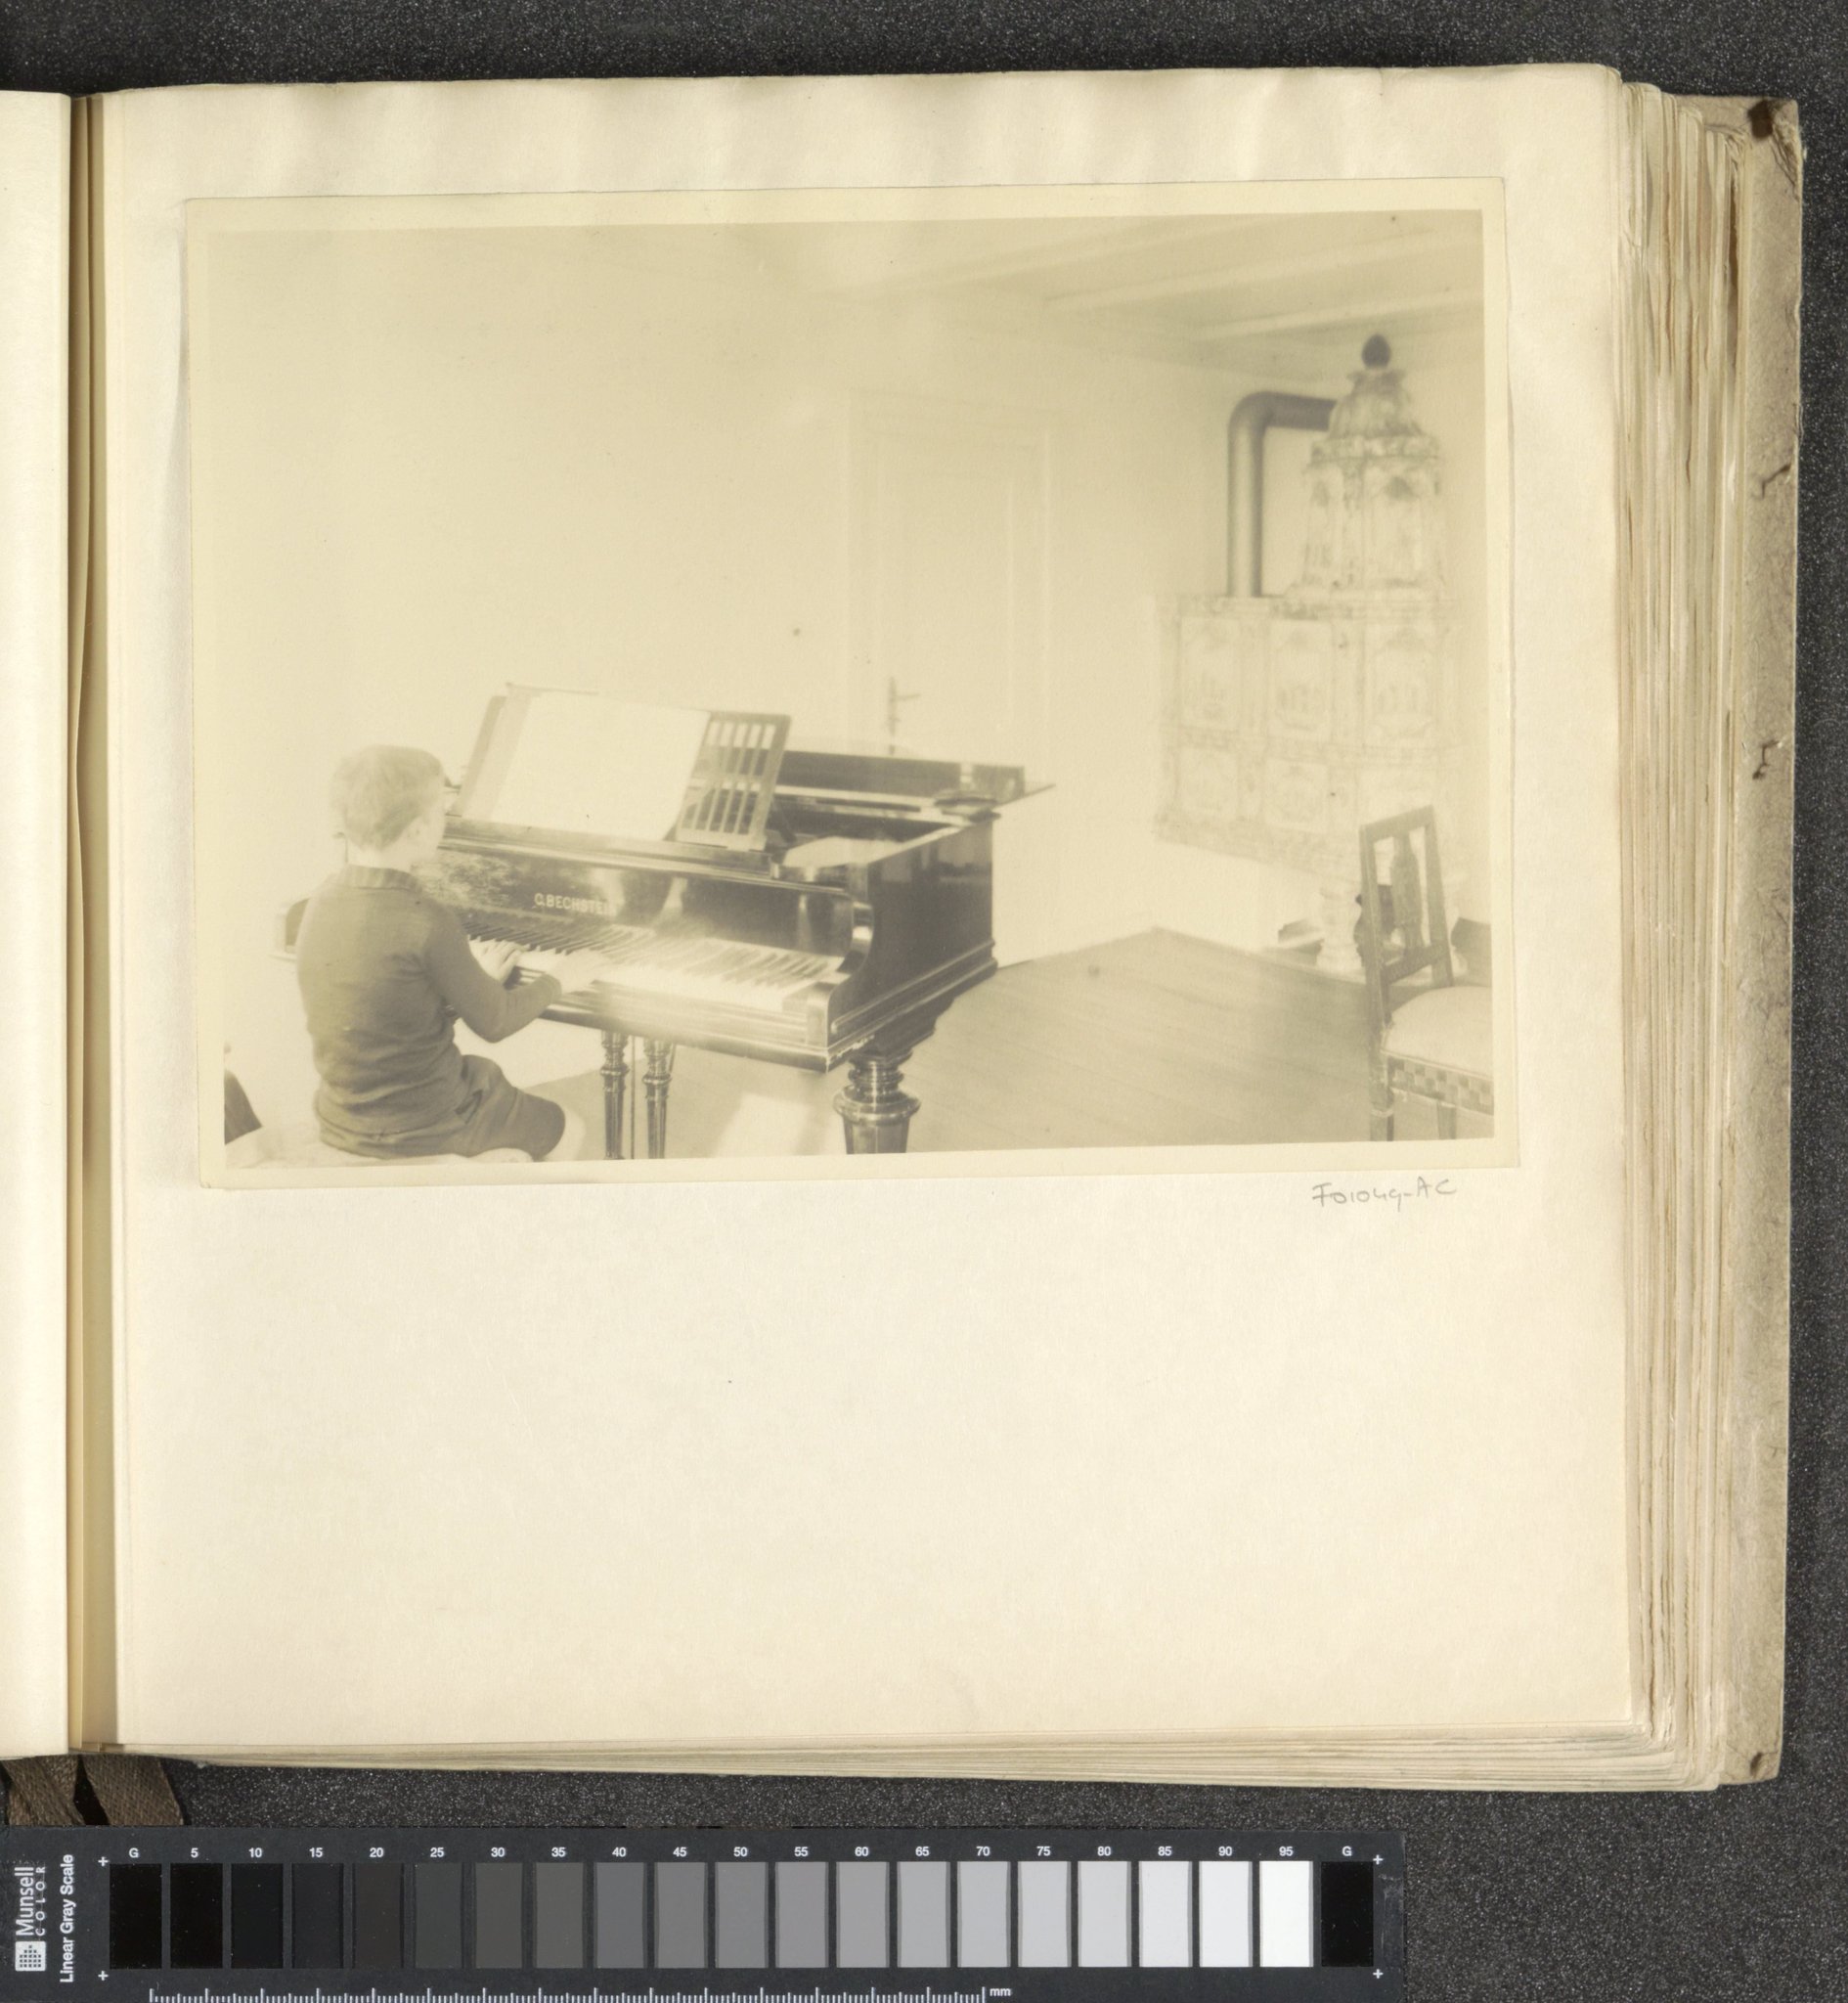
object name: photograph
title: Leerling van Schule Schloss Salem spelend op een Bechstein-vleugel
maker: Anonymous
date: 1929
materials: photographic support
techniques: gelatin silver print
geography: salem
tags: grand piano, education, heating stove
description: Onderdeel van Fotoalbum van Schule Schloss Salem.